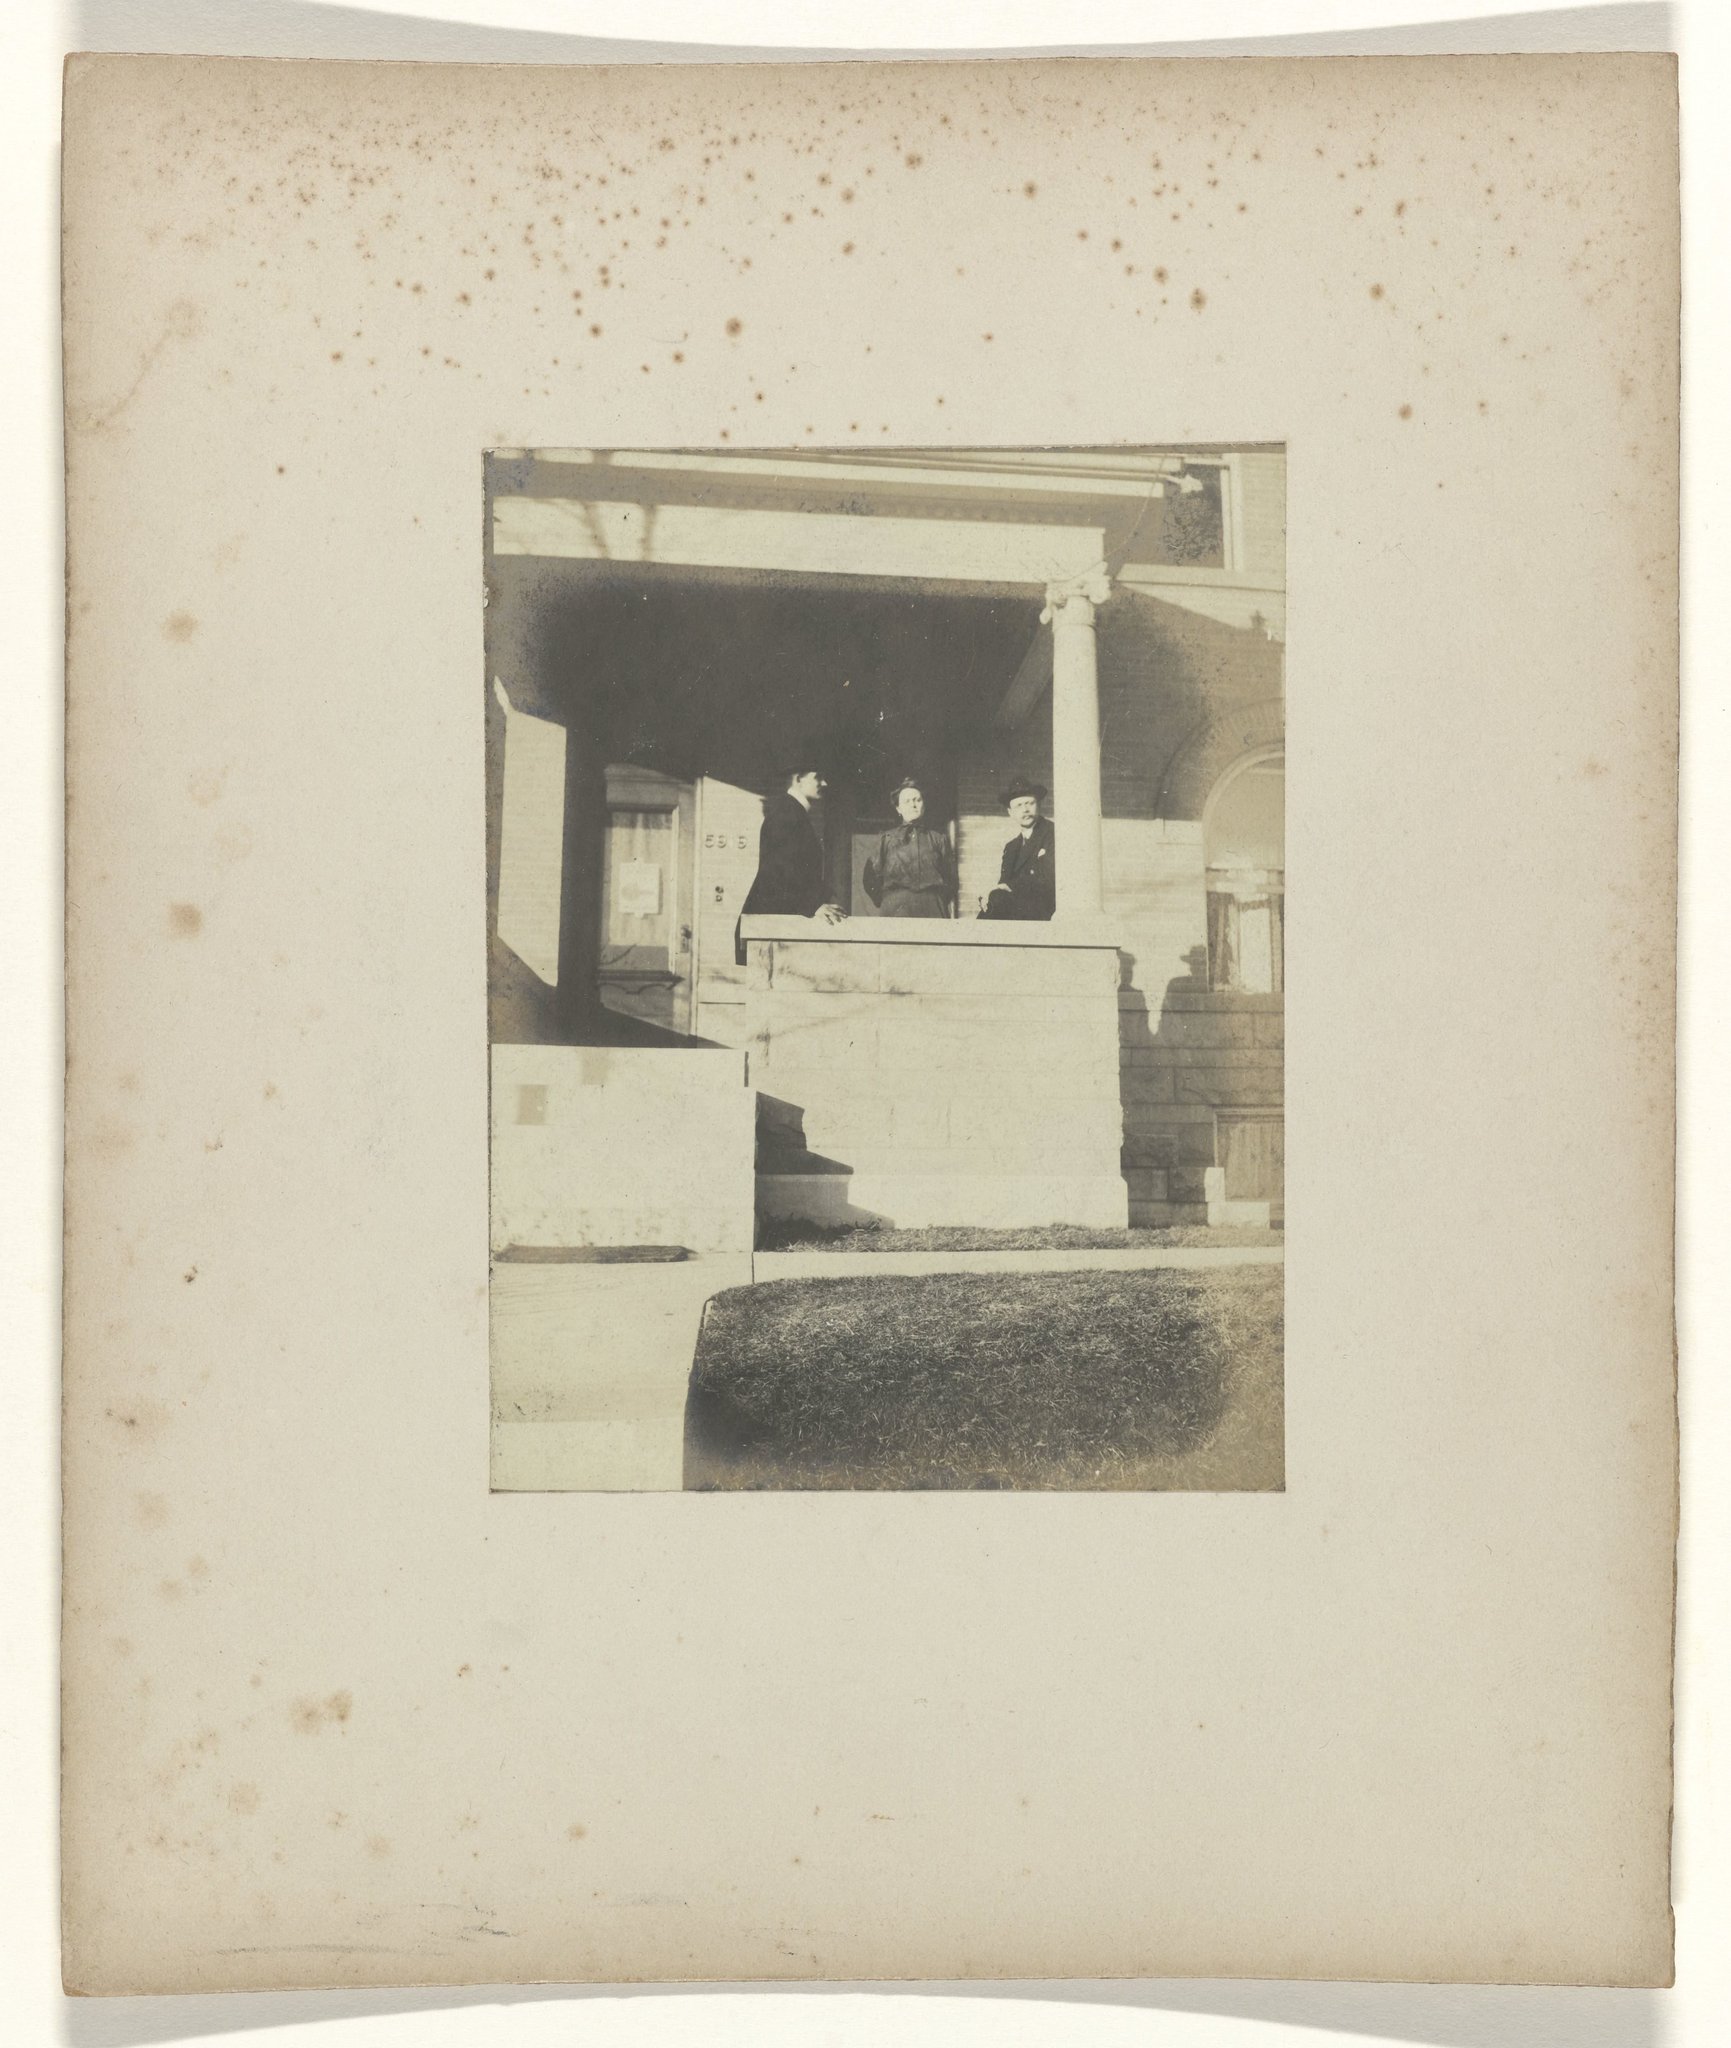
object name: photograph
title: Jan C. Schüller, Backers en Mrs. McDermott op de galerij van Maple Arc 5919 tijdens de wereldtentoonstelling in St. Louis (Louisiana Purchase Exposition), 1904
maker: Anonymous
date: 1904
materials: cardboard, paper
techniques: gelatin silver print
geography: saint louis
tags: painter, print maker, draughtsman, jan schüller, world fair, world exhibition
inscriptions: annotation: ‘Op de porch van // maple arc 5919 // Backers, Mrs mcDermott // en J.C.S.’, annotation: ‘Jan C. Schüller’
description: Jan C. Schüller, Backers en Mrs. McDermott op de galerij van Maple Arc 5919 tijdens de wereldtentoonstelling in St. Louis (Louisiana Purchase Exposition), 1904.